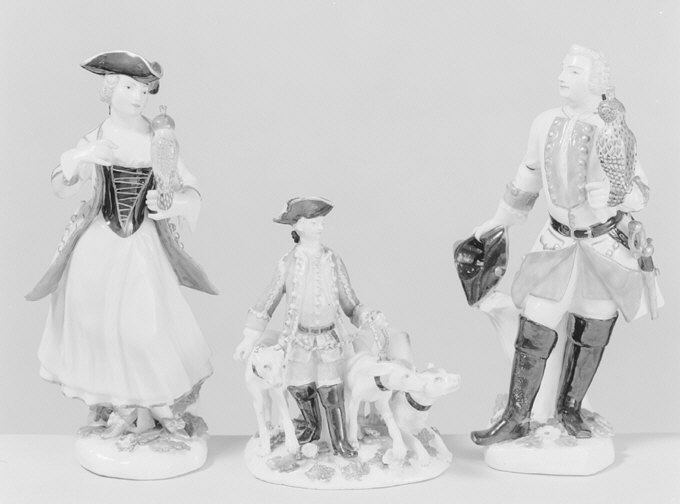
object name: figure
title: Falconer (one of a pair)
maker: meissen manufactory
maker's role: manufactory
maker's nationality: german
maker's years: 1710-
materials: hard paste porcelain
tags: falcons,boys,men,women